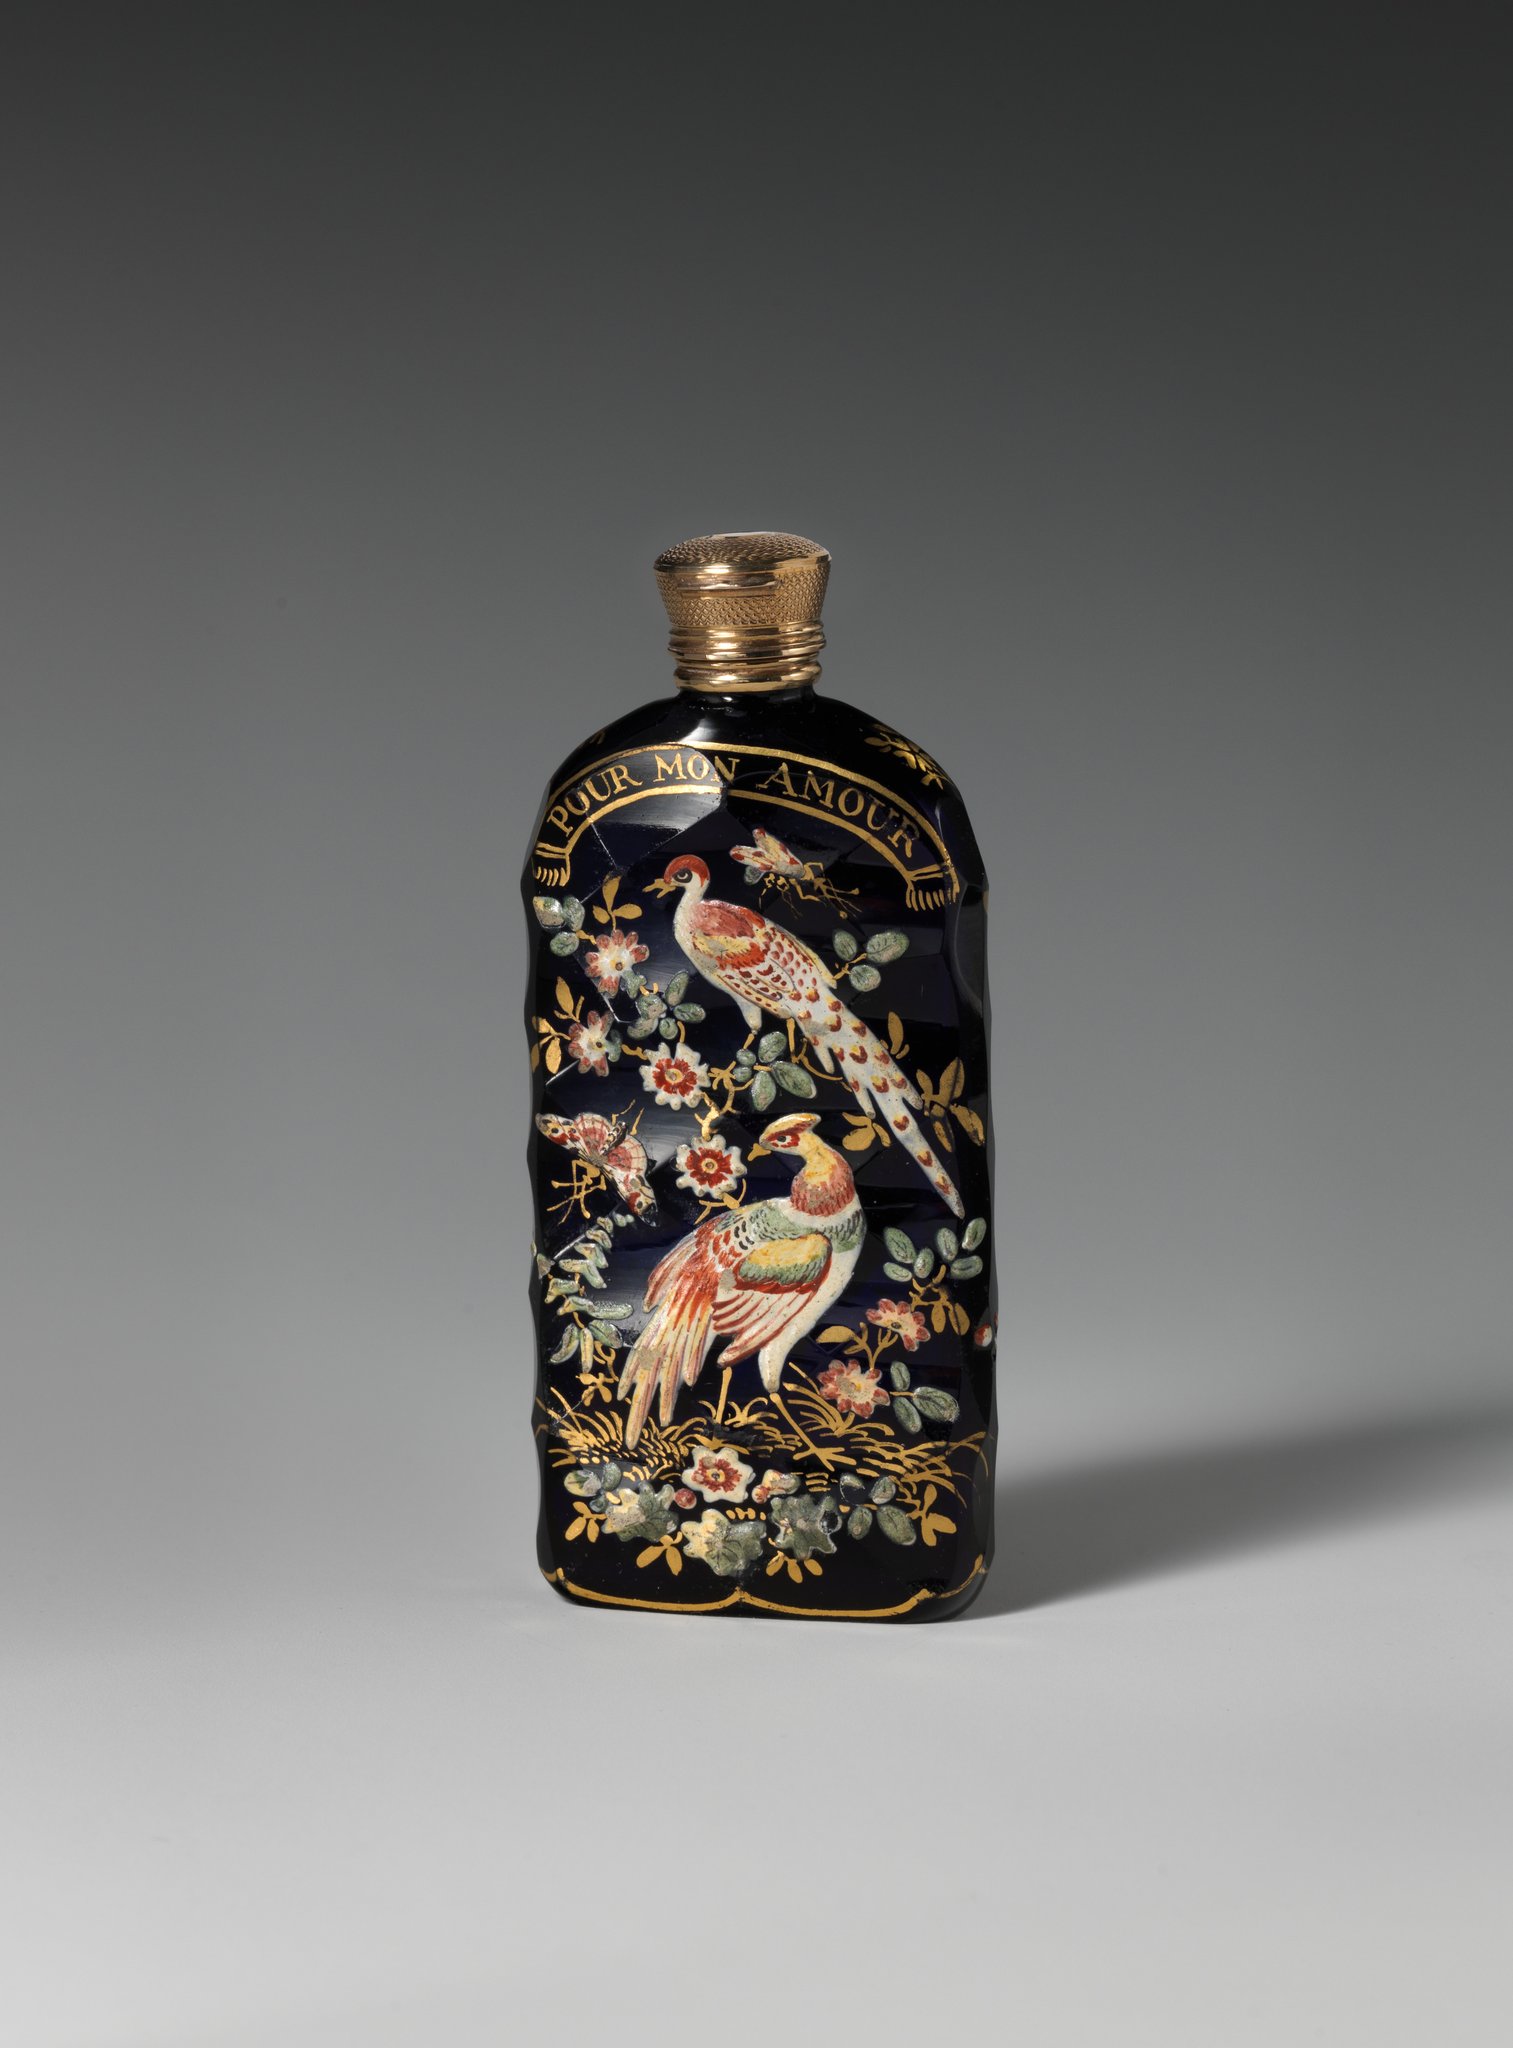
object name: scent bottle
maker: giles atelier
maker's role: decorator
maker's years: 1725-1825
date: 1770-1780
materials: glass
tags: birds,flowers